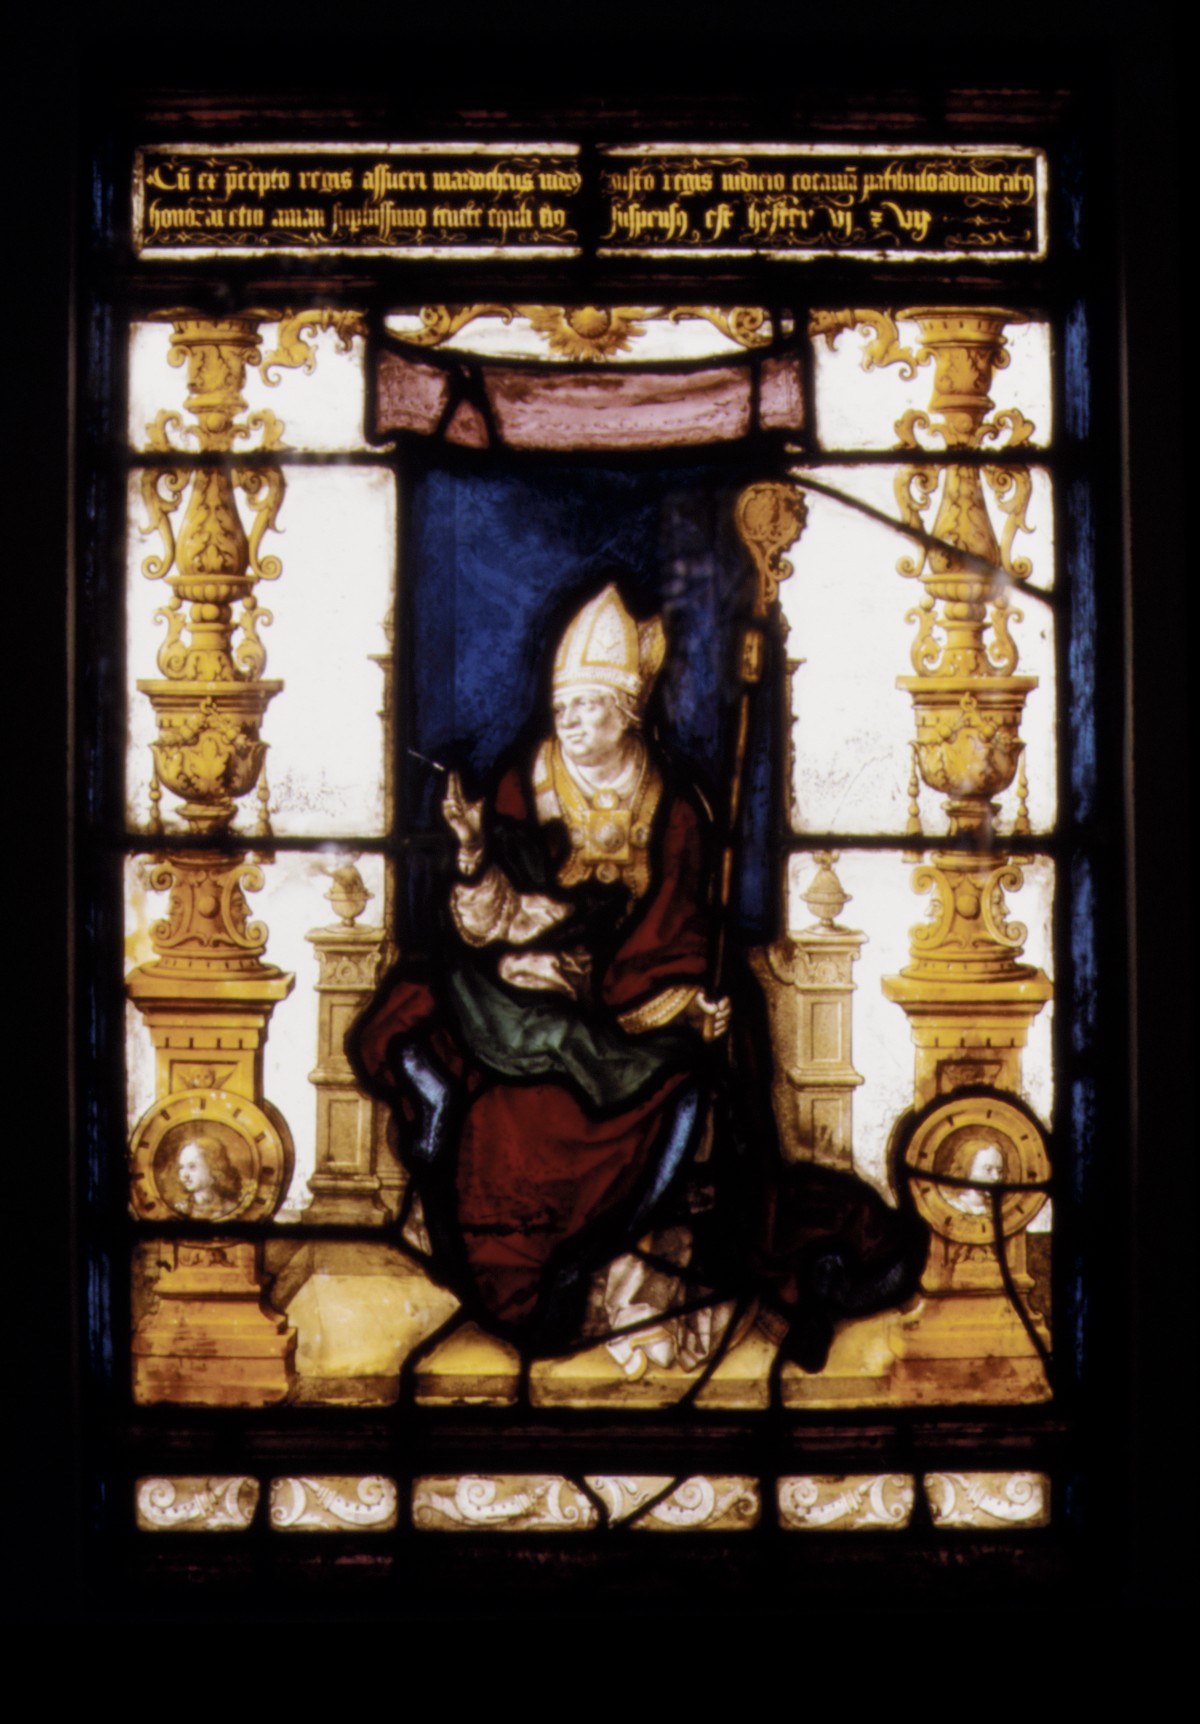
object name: panel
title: Panel depicting a seated bishop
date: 1525-1530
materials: glass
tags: bishops